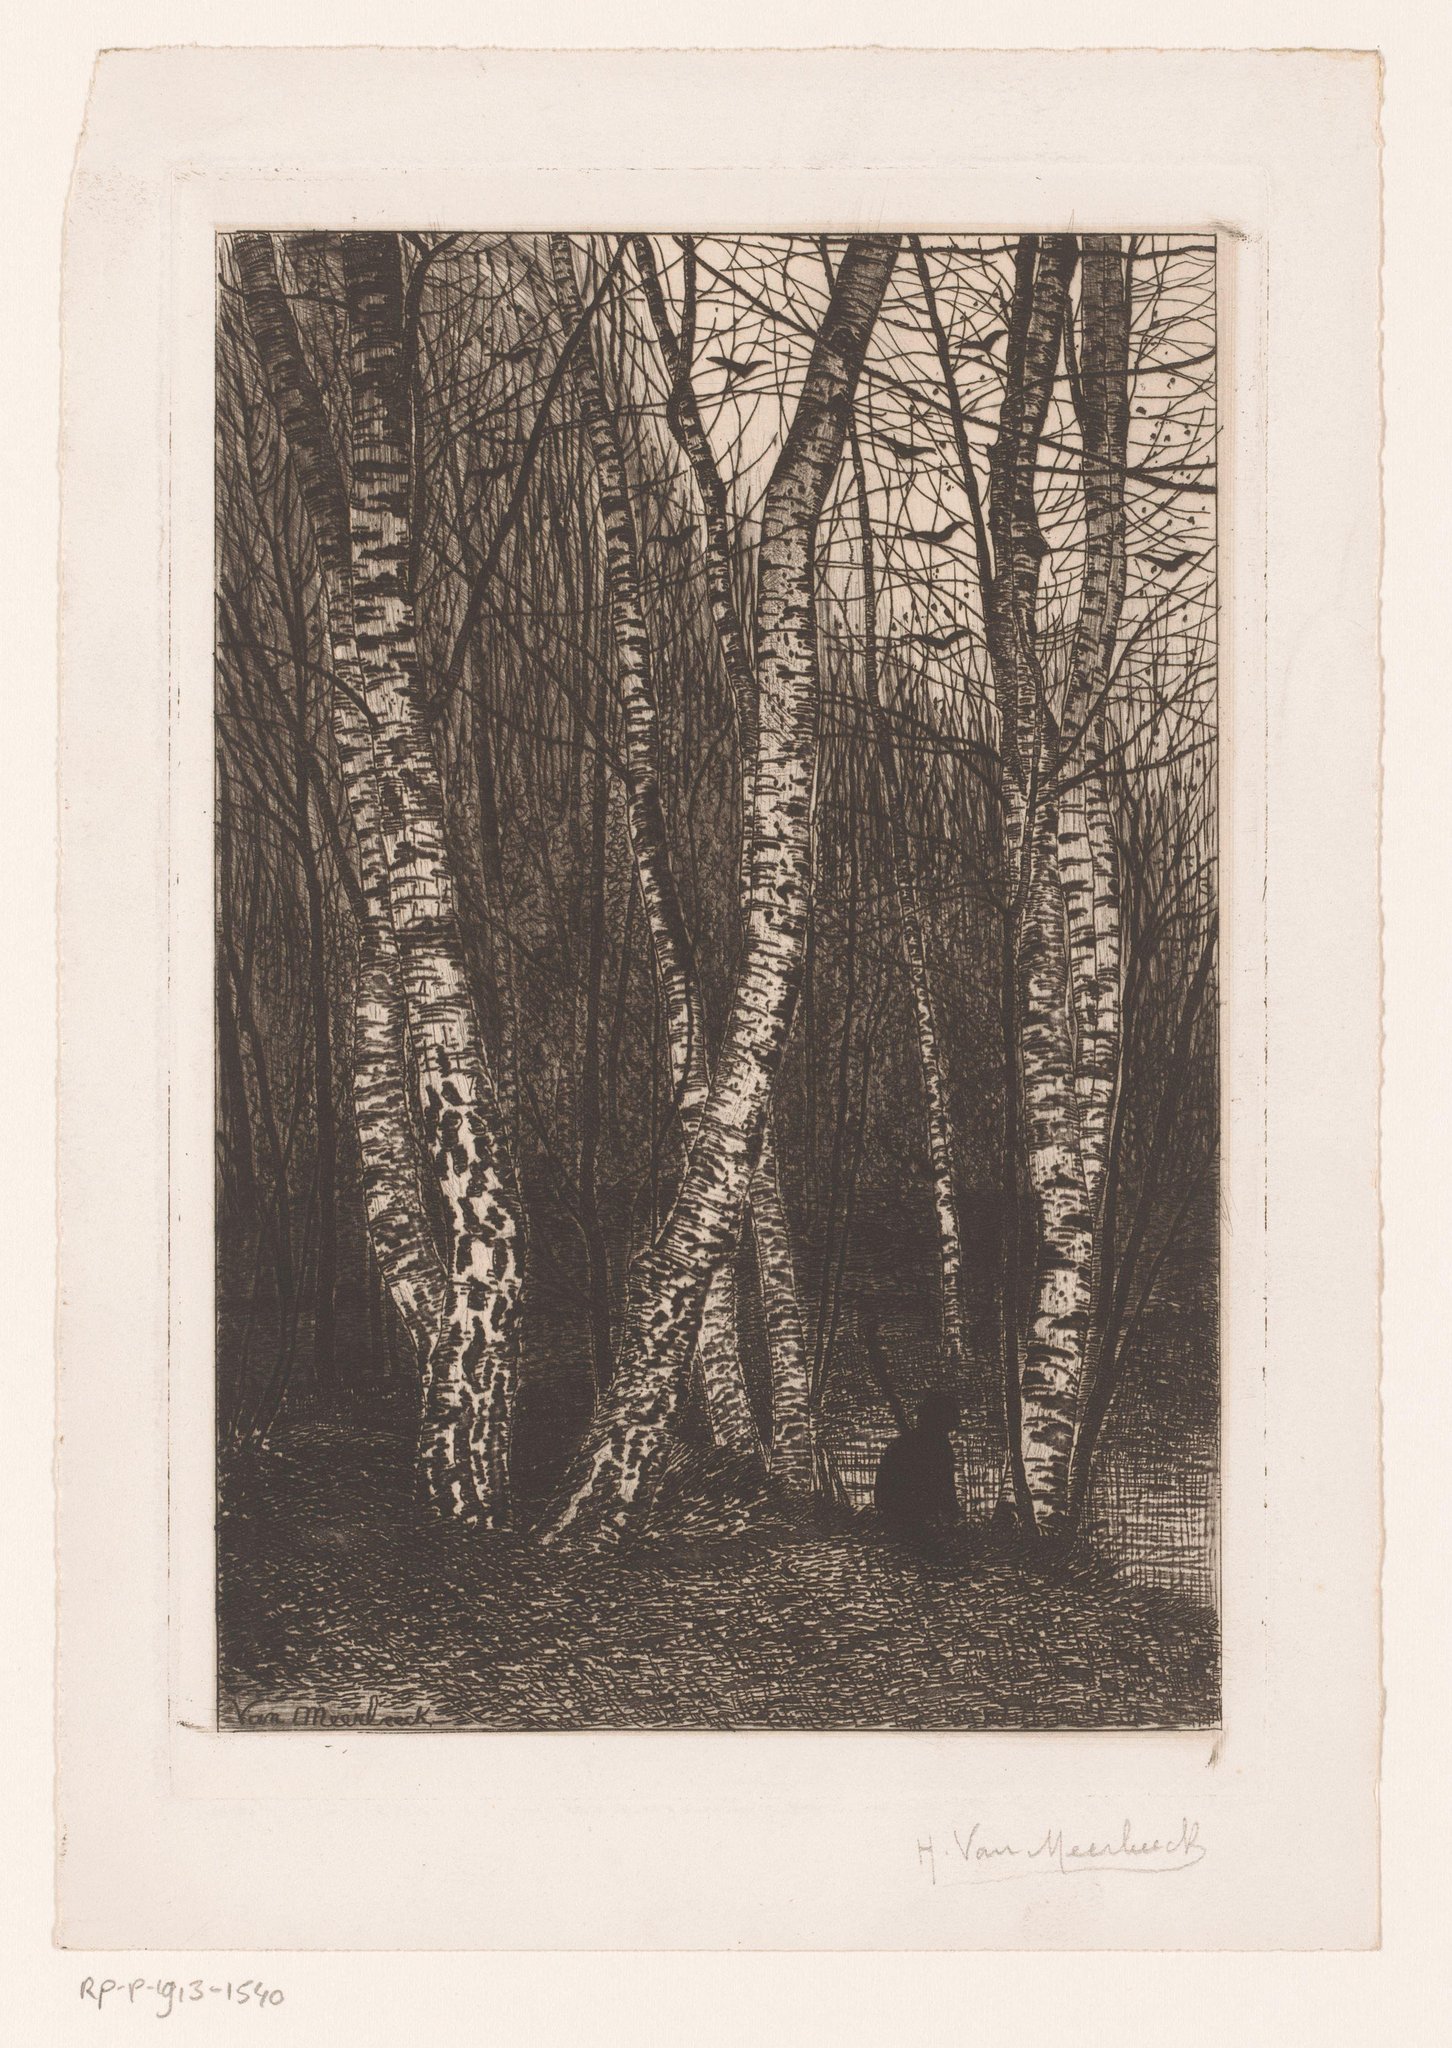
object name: print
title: Landschap met berken en een figuur aan het water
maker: h. van meerbeeck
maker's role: print maker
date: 1850-1913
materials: paper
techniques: etching, intaglio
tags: landscapes with waters, waterscapes, seascapes (in the temperate zone), trees: birch, forest, wood (+ landscape with figures, staffage)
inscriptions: collector's mark: Lugt 2228